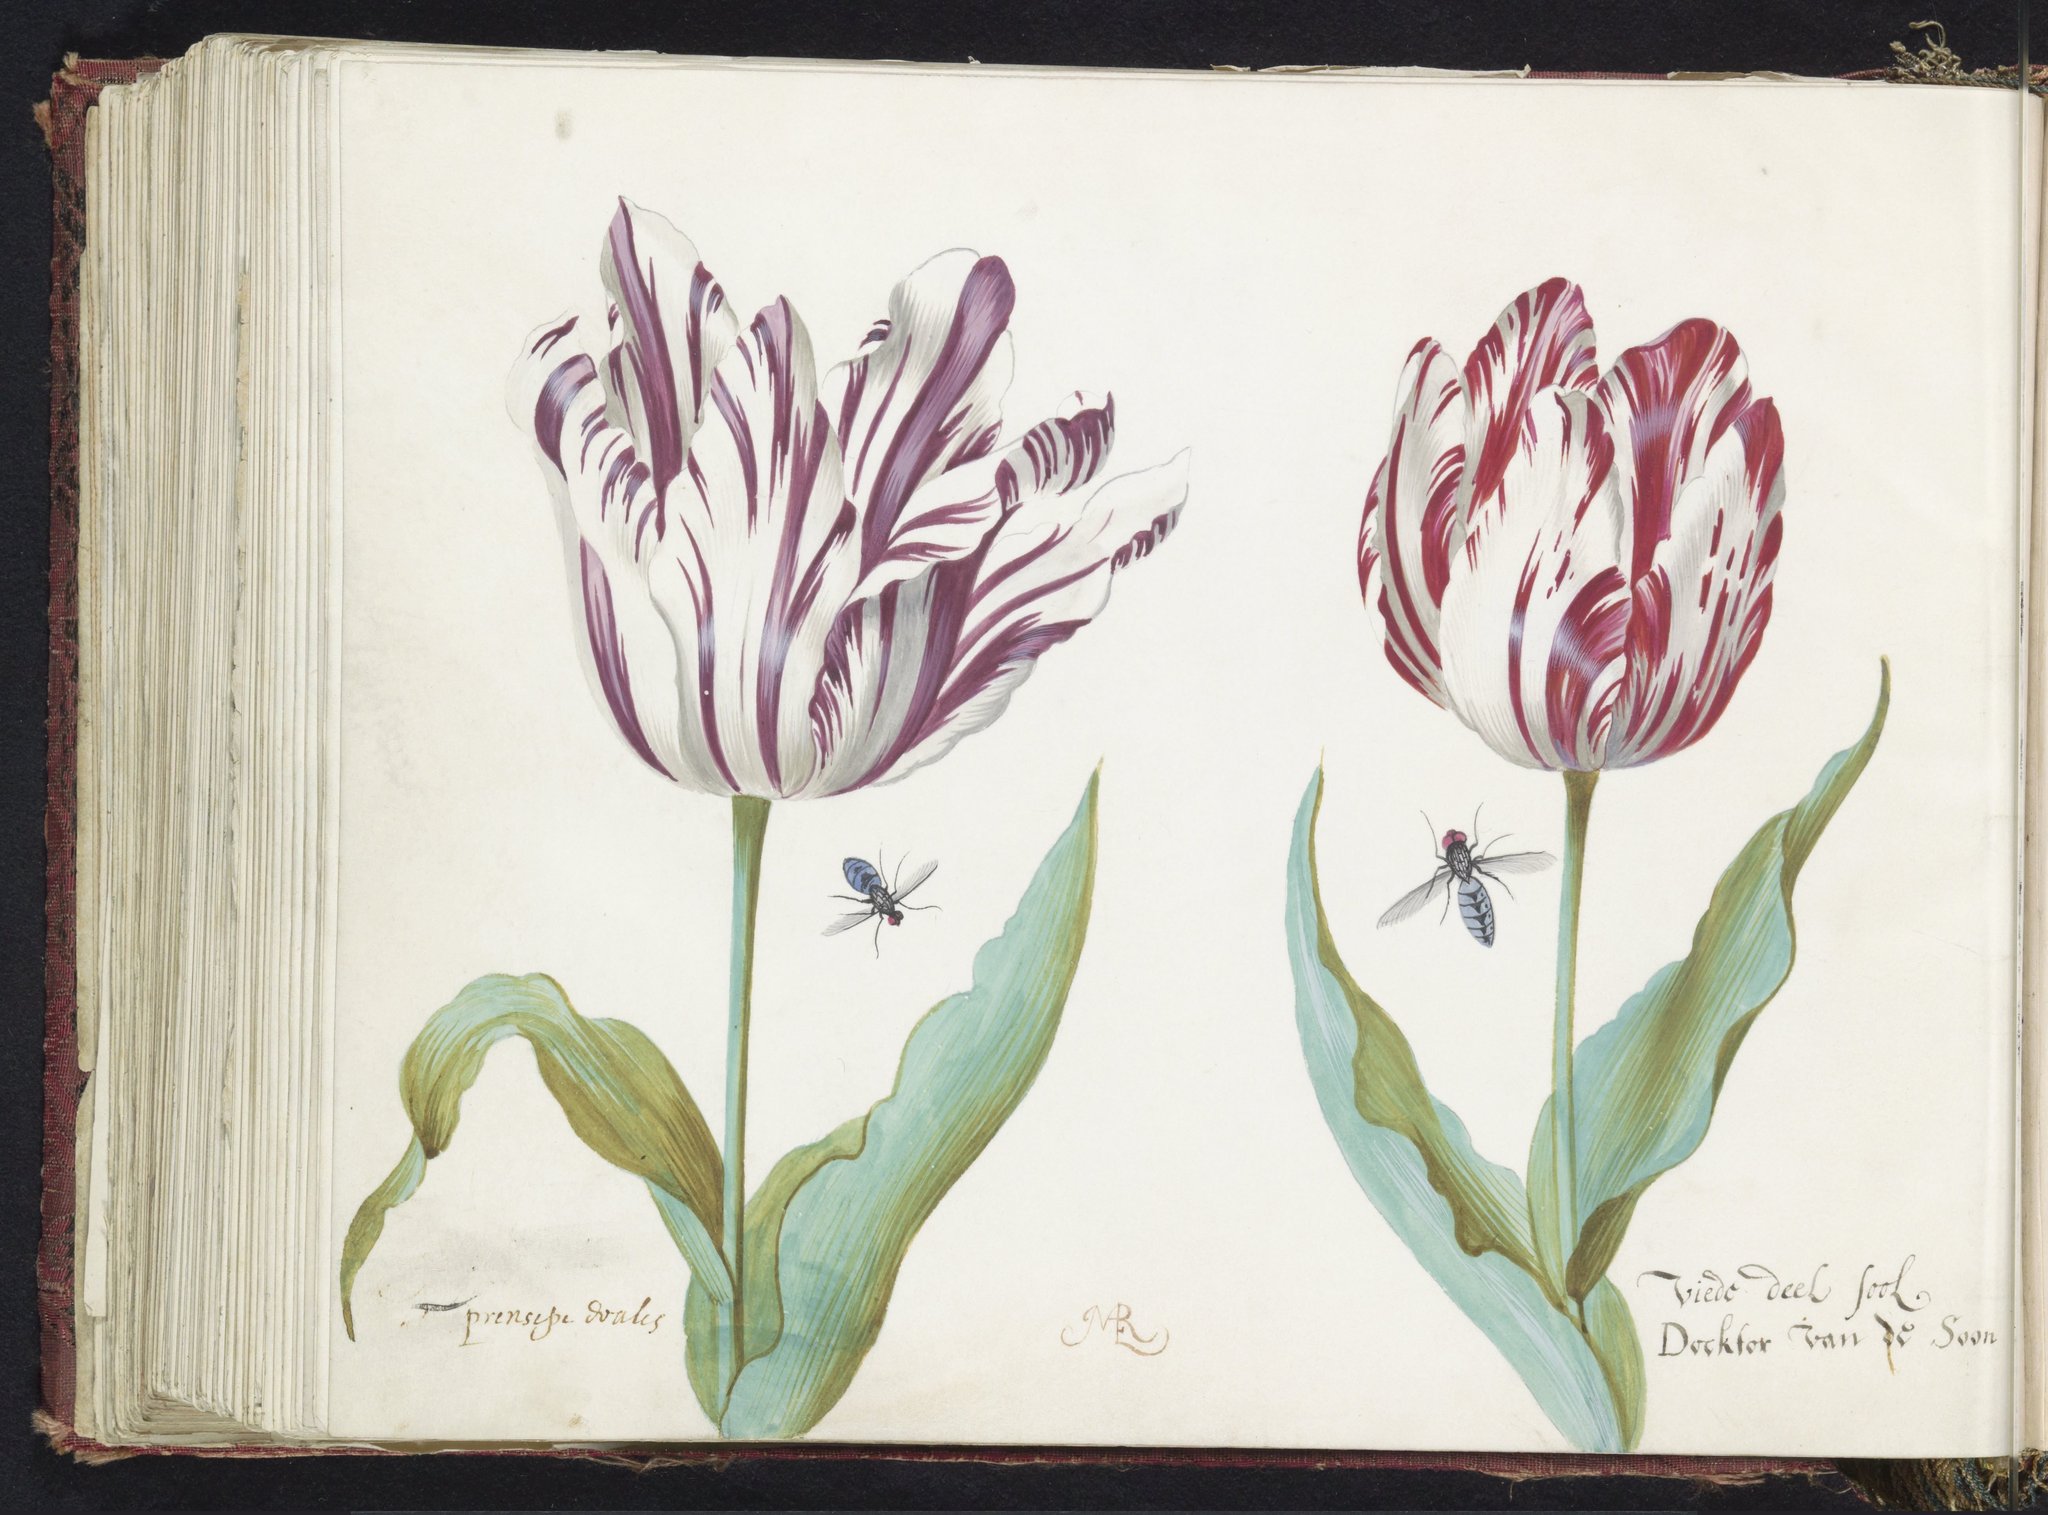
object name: album leaf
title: Prinsipe duales / viede deel sool Docktor van de Soon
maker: jacob marrel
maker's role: draughtsman, painter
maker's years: 1614-1681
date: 1640-1645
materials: paint, parchment, pencil, watercolor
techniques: brush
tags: flowers: tulip, insects: fly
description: De tekening maakt deel uit van een album.